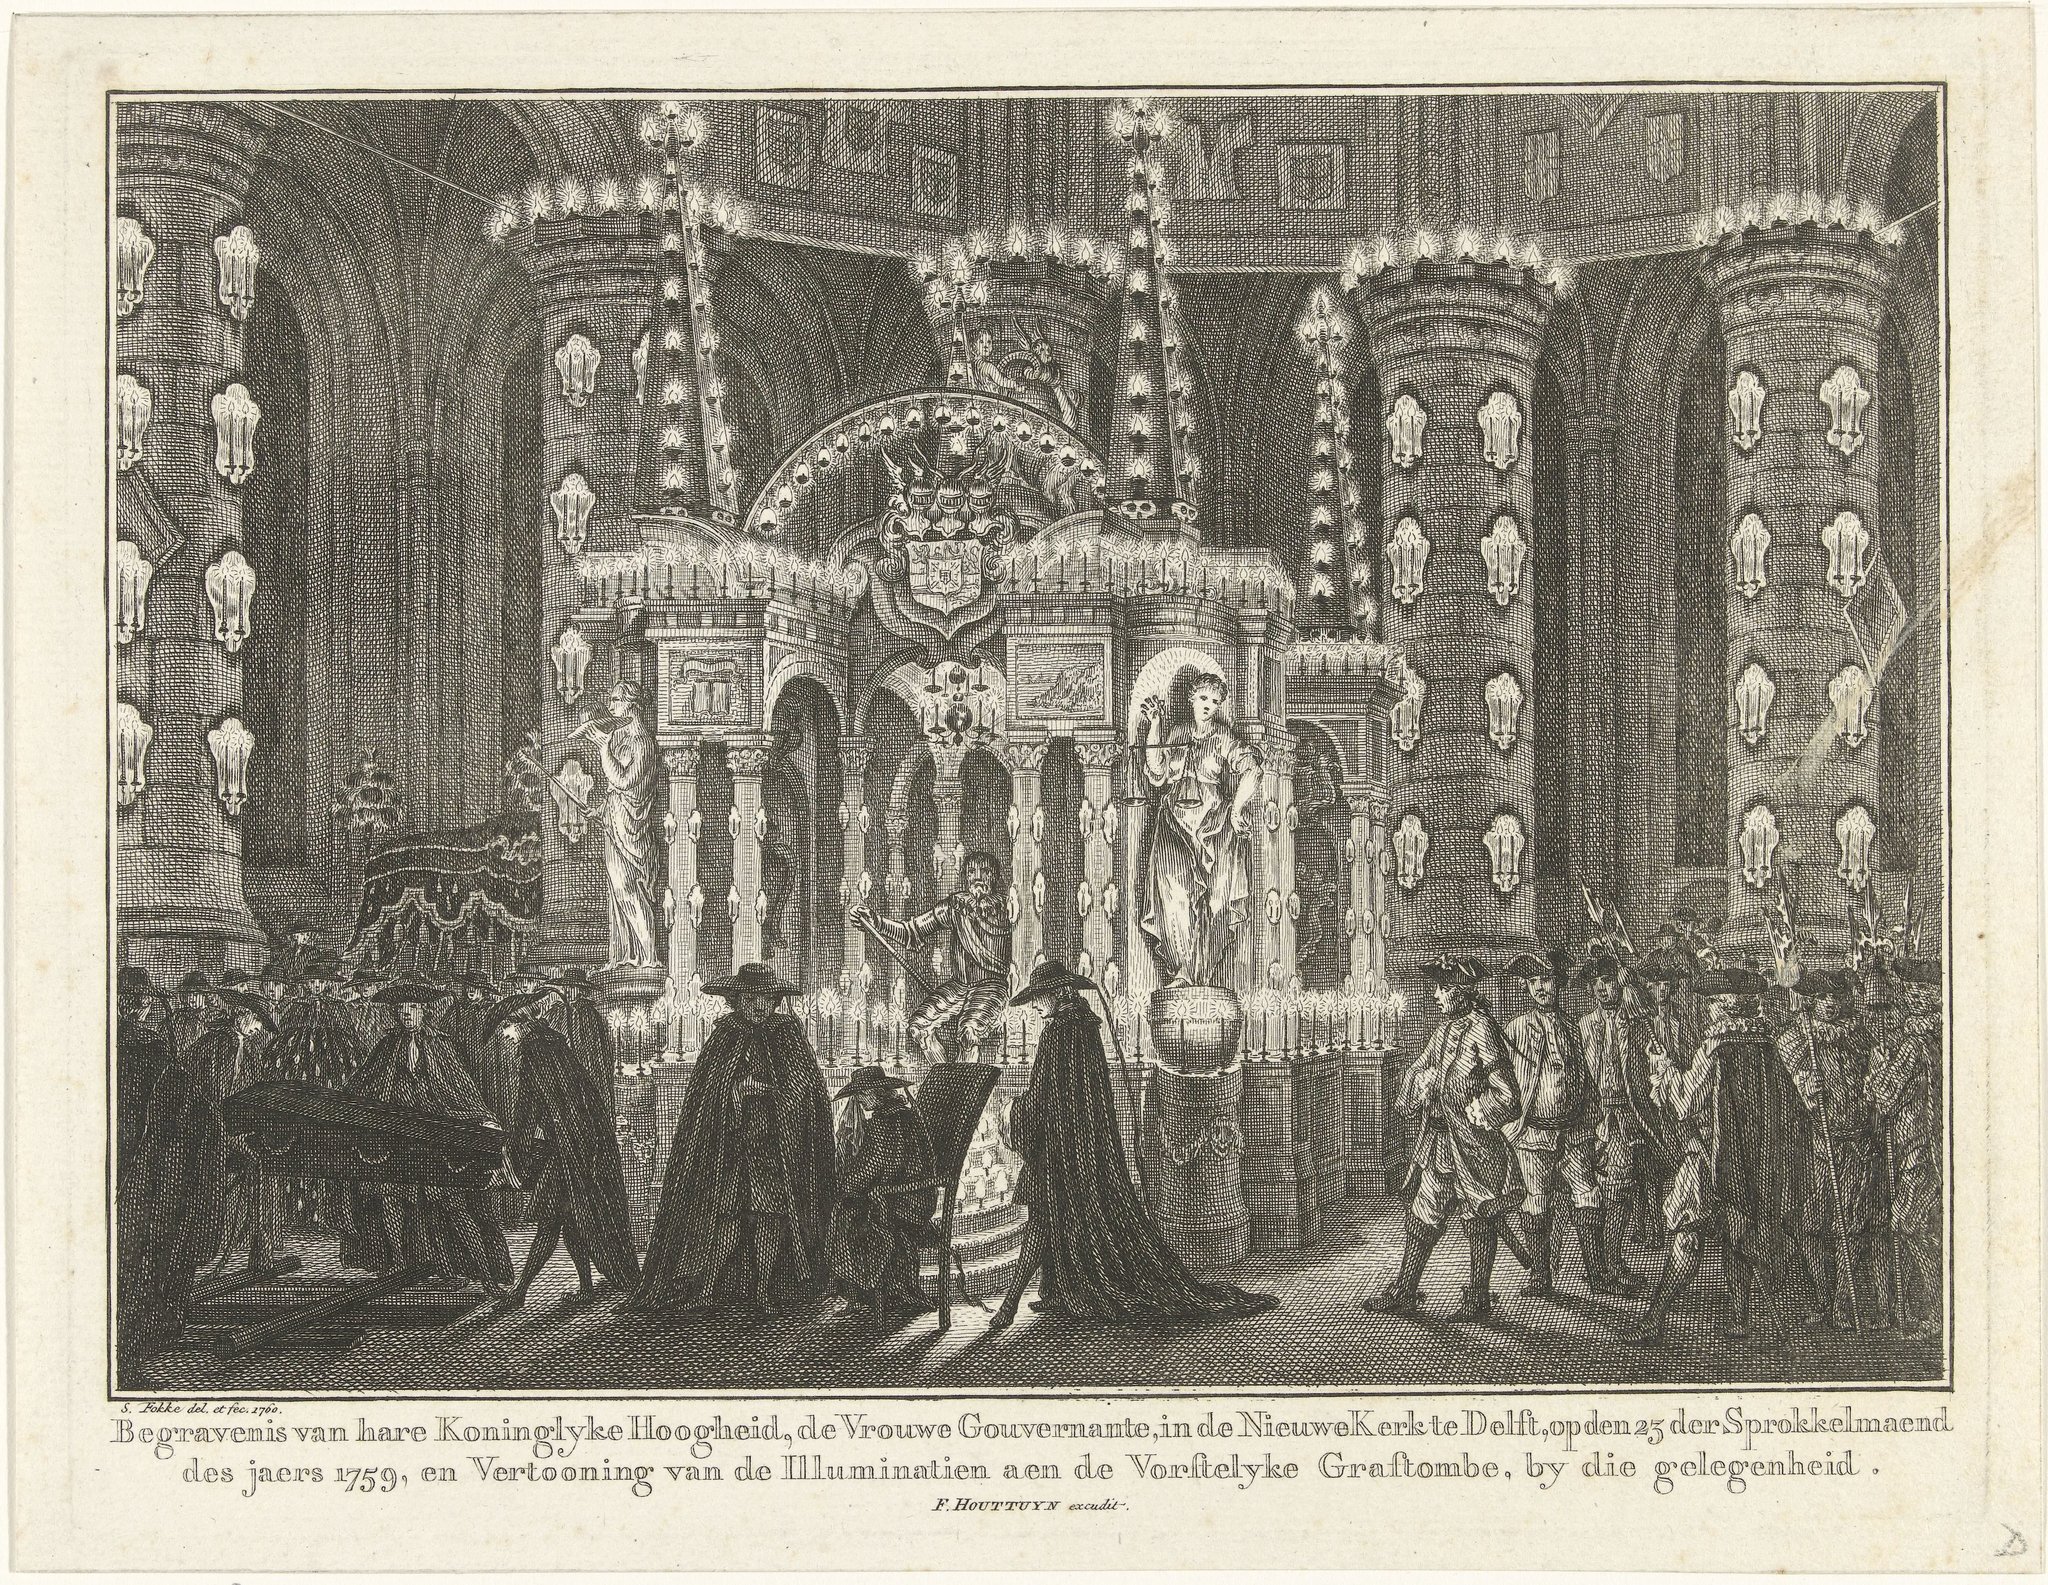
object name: print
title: Begrafenis van Anna van Hannover in de Nieuwe Kerk te Delft, 1759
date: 1760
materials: paper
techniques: etching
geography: amsterdam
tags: anna van hannover, burial, grave-building, monumental tomb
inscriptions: collector's mark: Lugt 2228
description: Begrafenis van Anna van Hannover, prinses van Oranje-Nassau, in de Nieuwe Kerk te Delft. De graftombe is verlicht met talloze kaarsen.